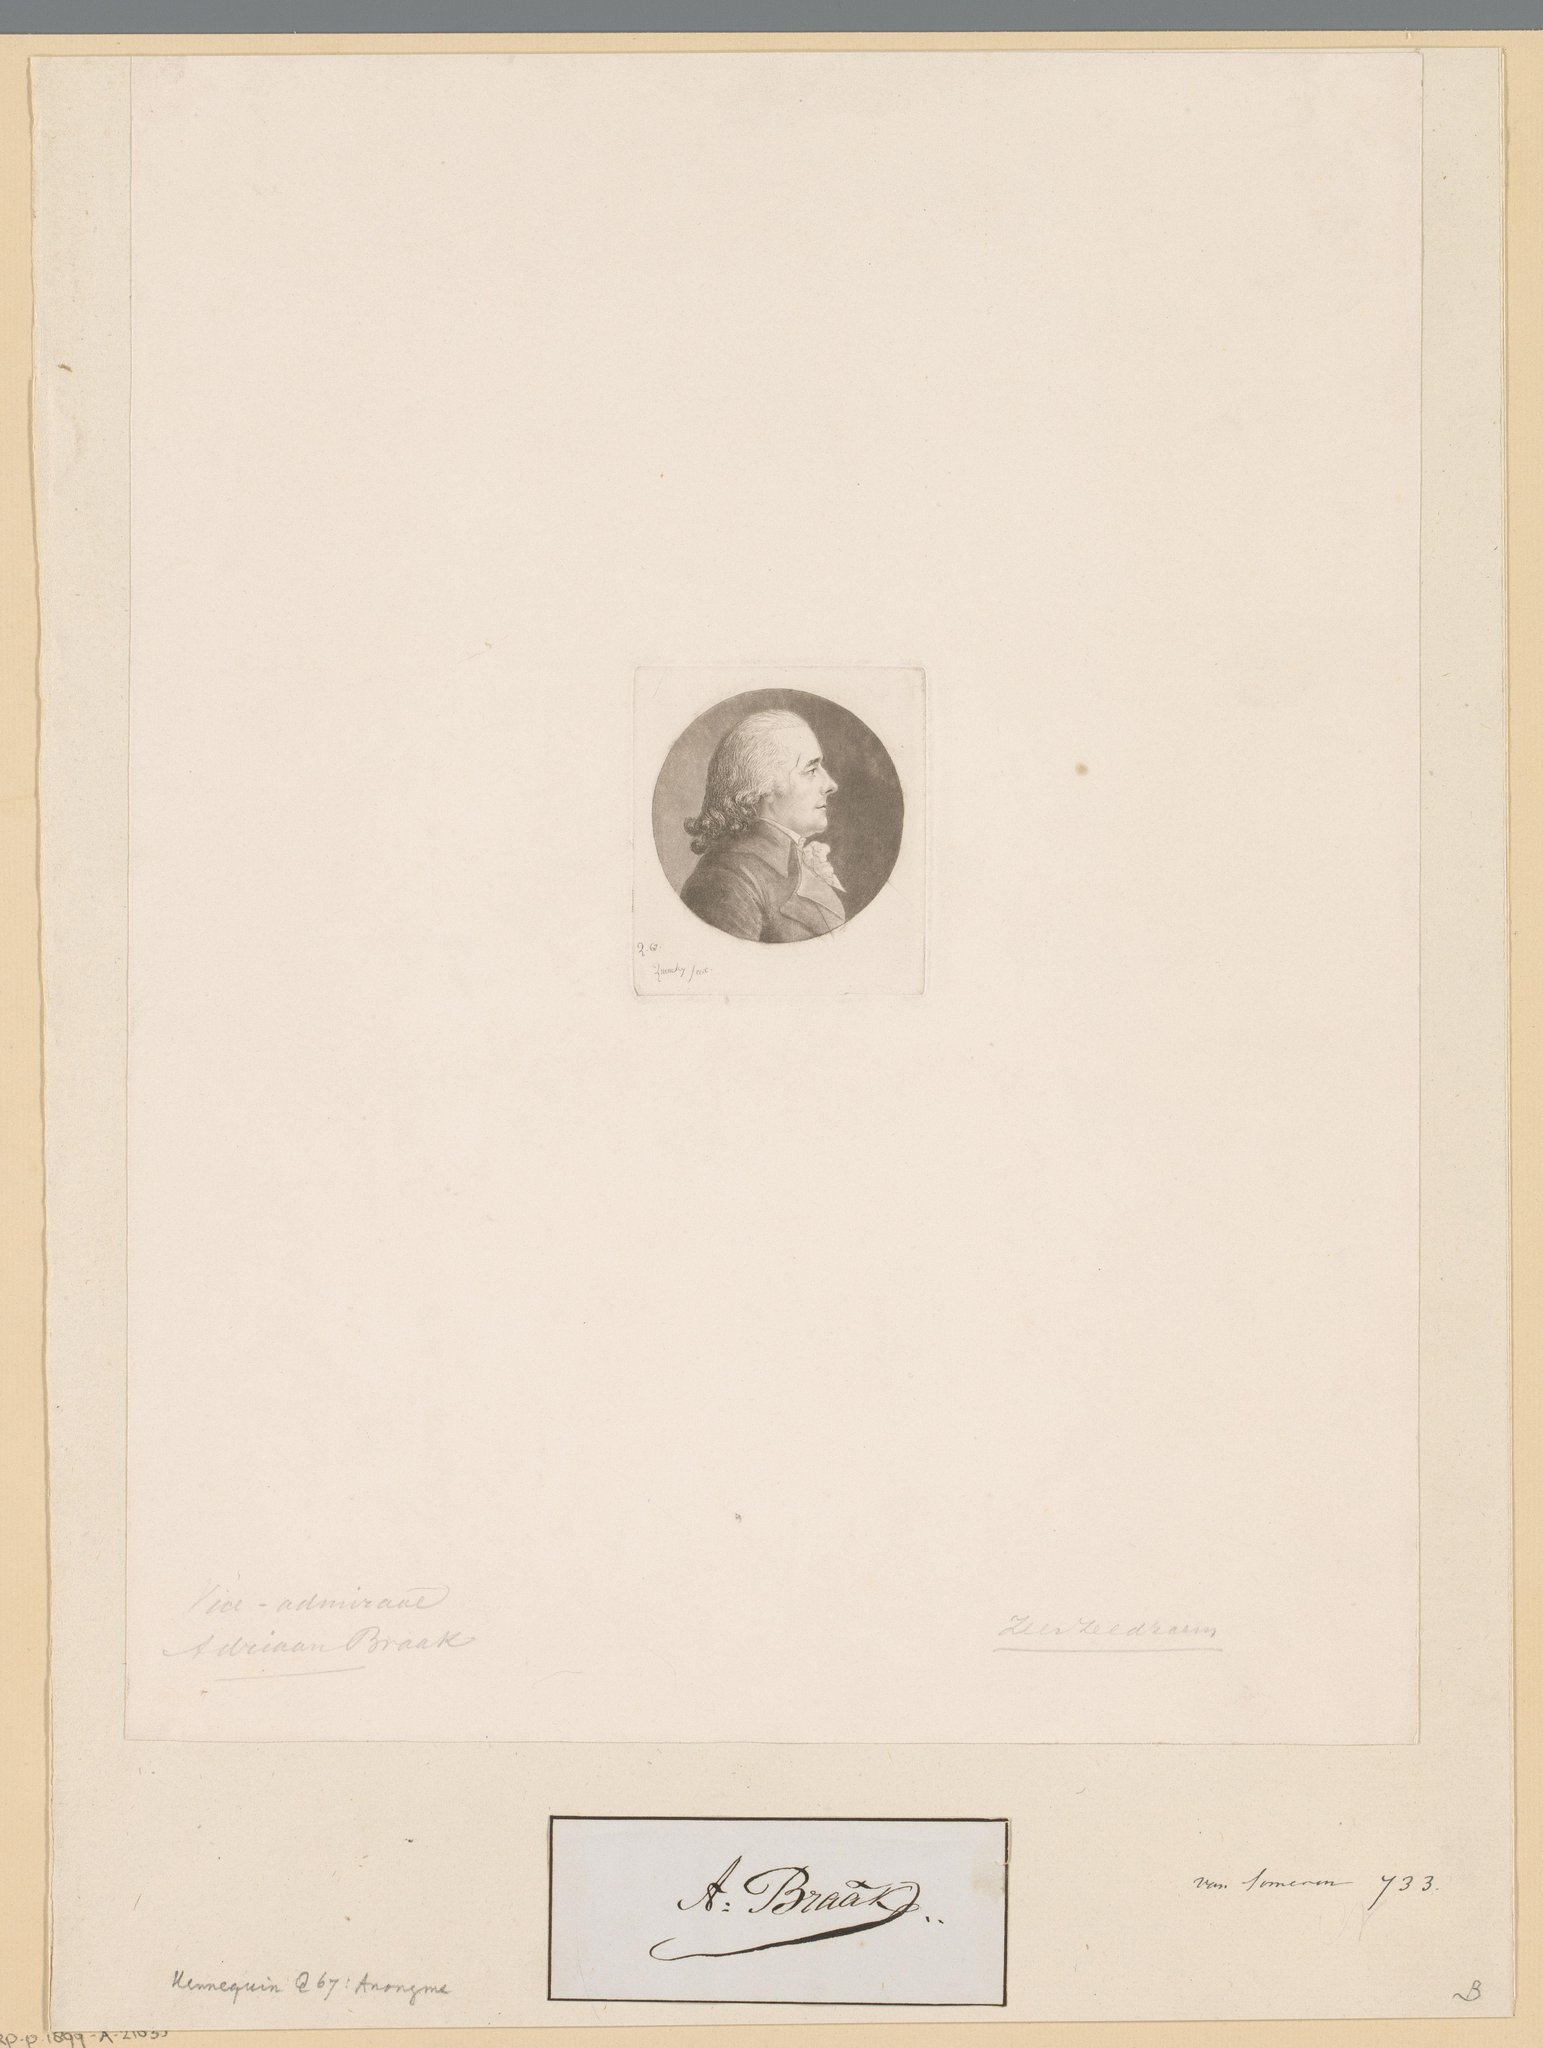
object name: print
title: Portret van Adriaan Braak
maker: edme quenedey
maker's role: print maker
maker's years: 1756-1830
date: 1785-1796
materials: paper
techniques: aquatint, etching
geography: paris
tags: silhouette-apparatus, 'physionotrace', historical persons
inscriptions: collector's mark: Lugt 2228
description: Onder het portret is op het opzetvel een reproductie van de handtekening van de afgebeelde persoon geplakt. Physionotrace portret.